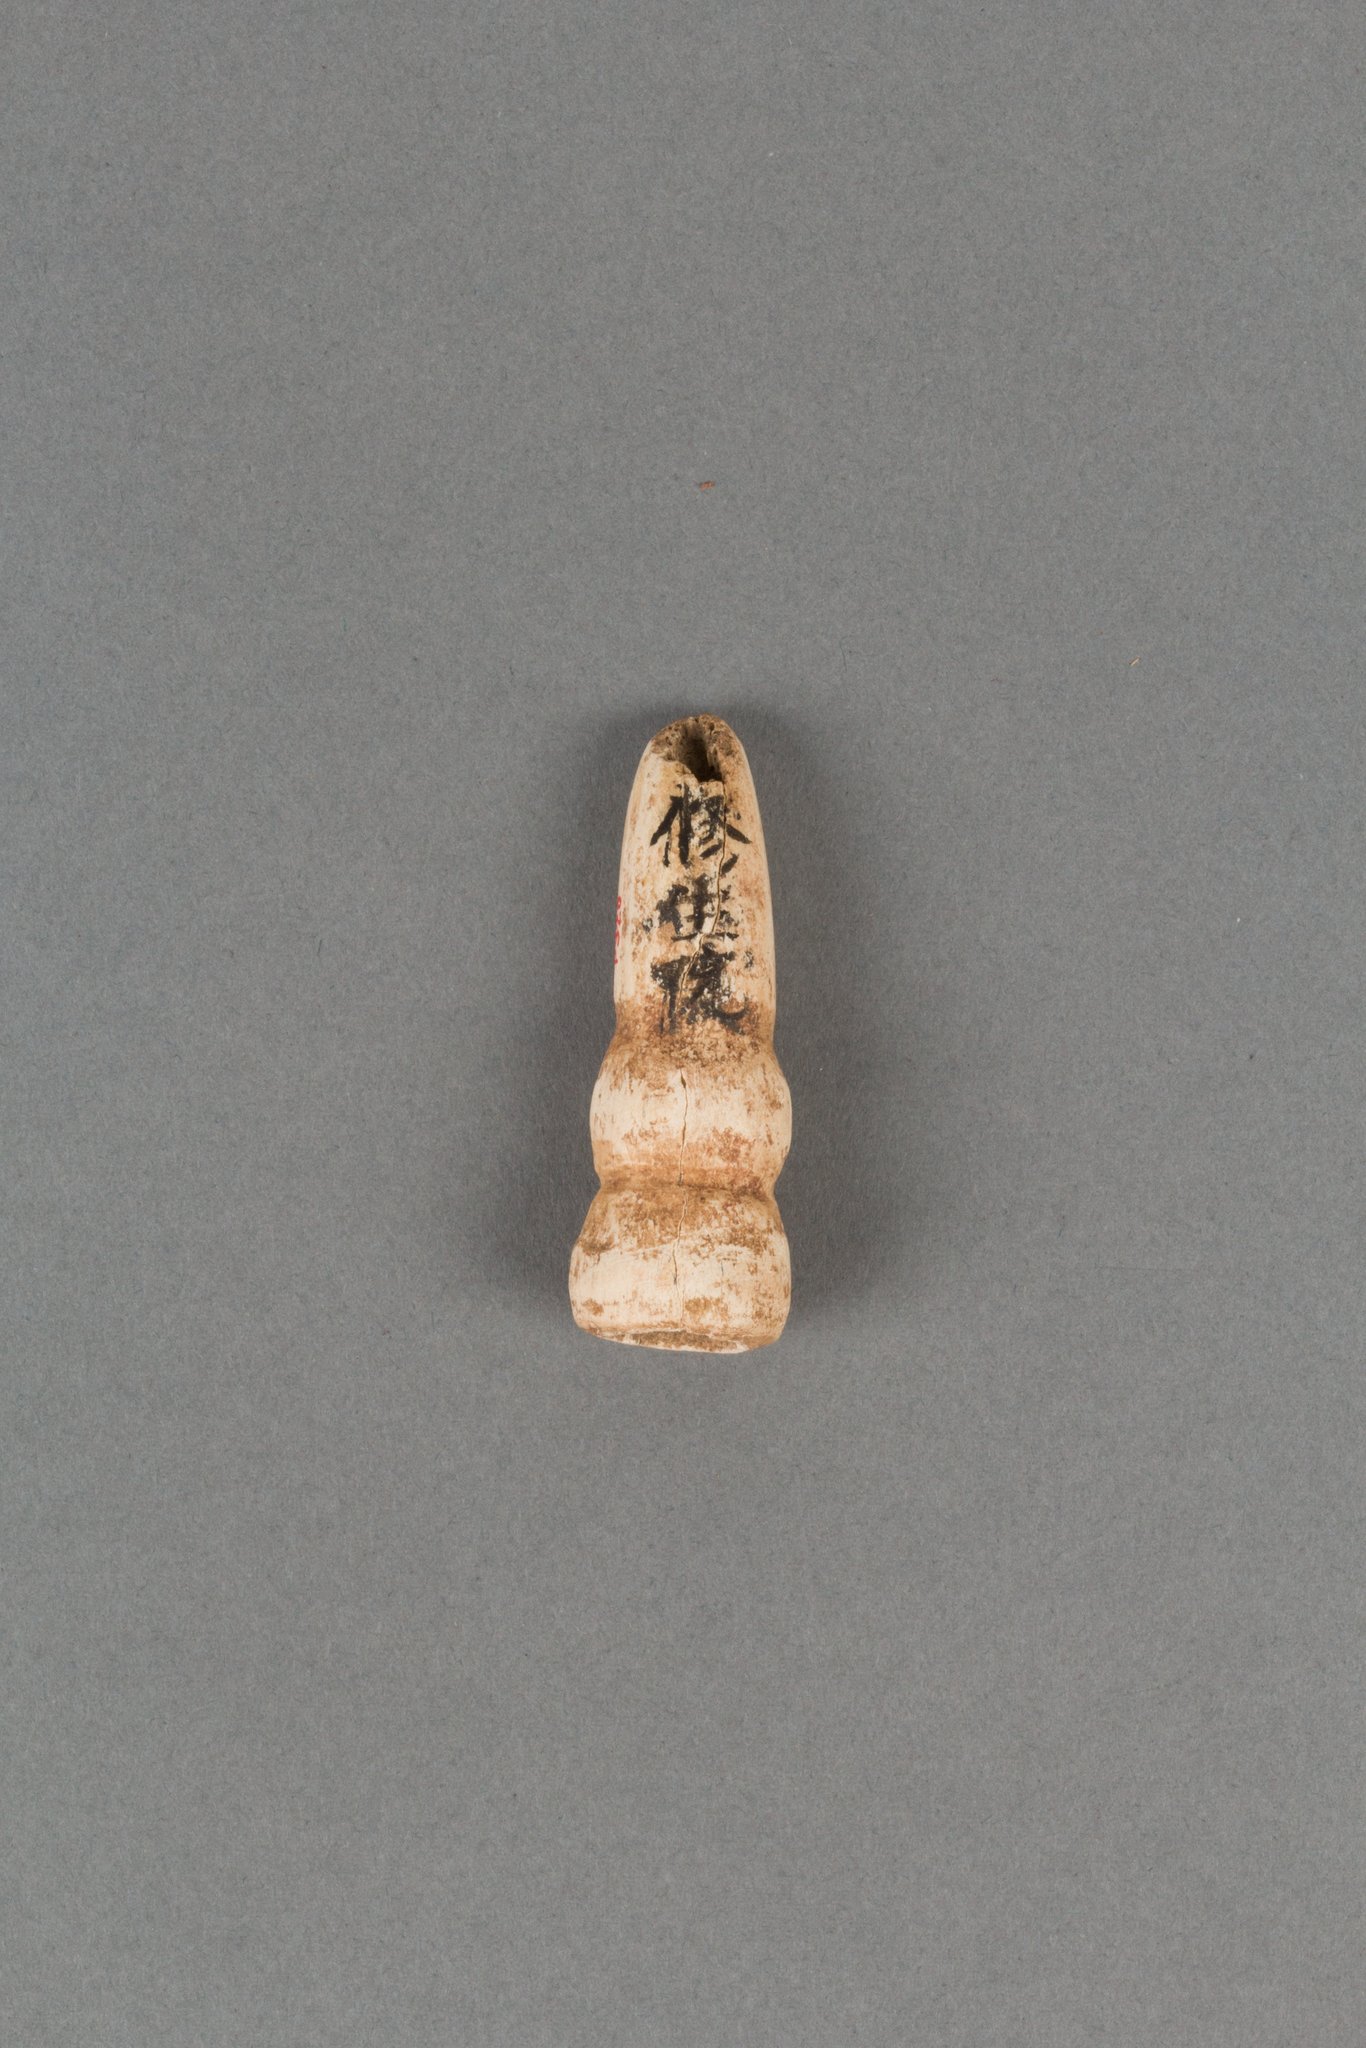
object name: nock of a bow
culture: japanese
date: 1200-200 BCE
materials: bone